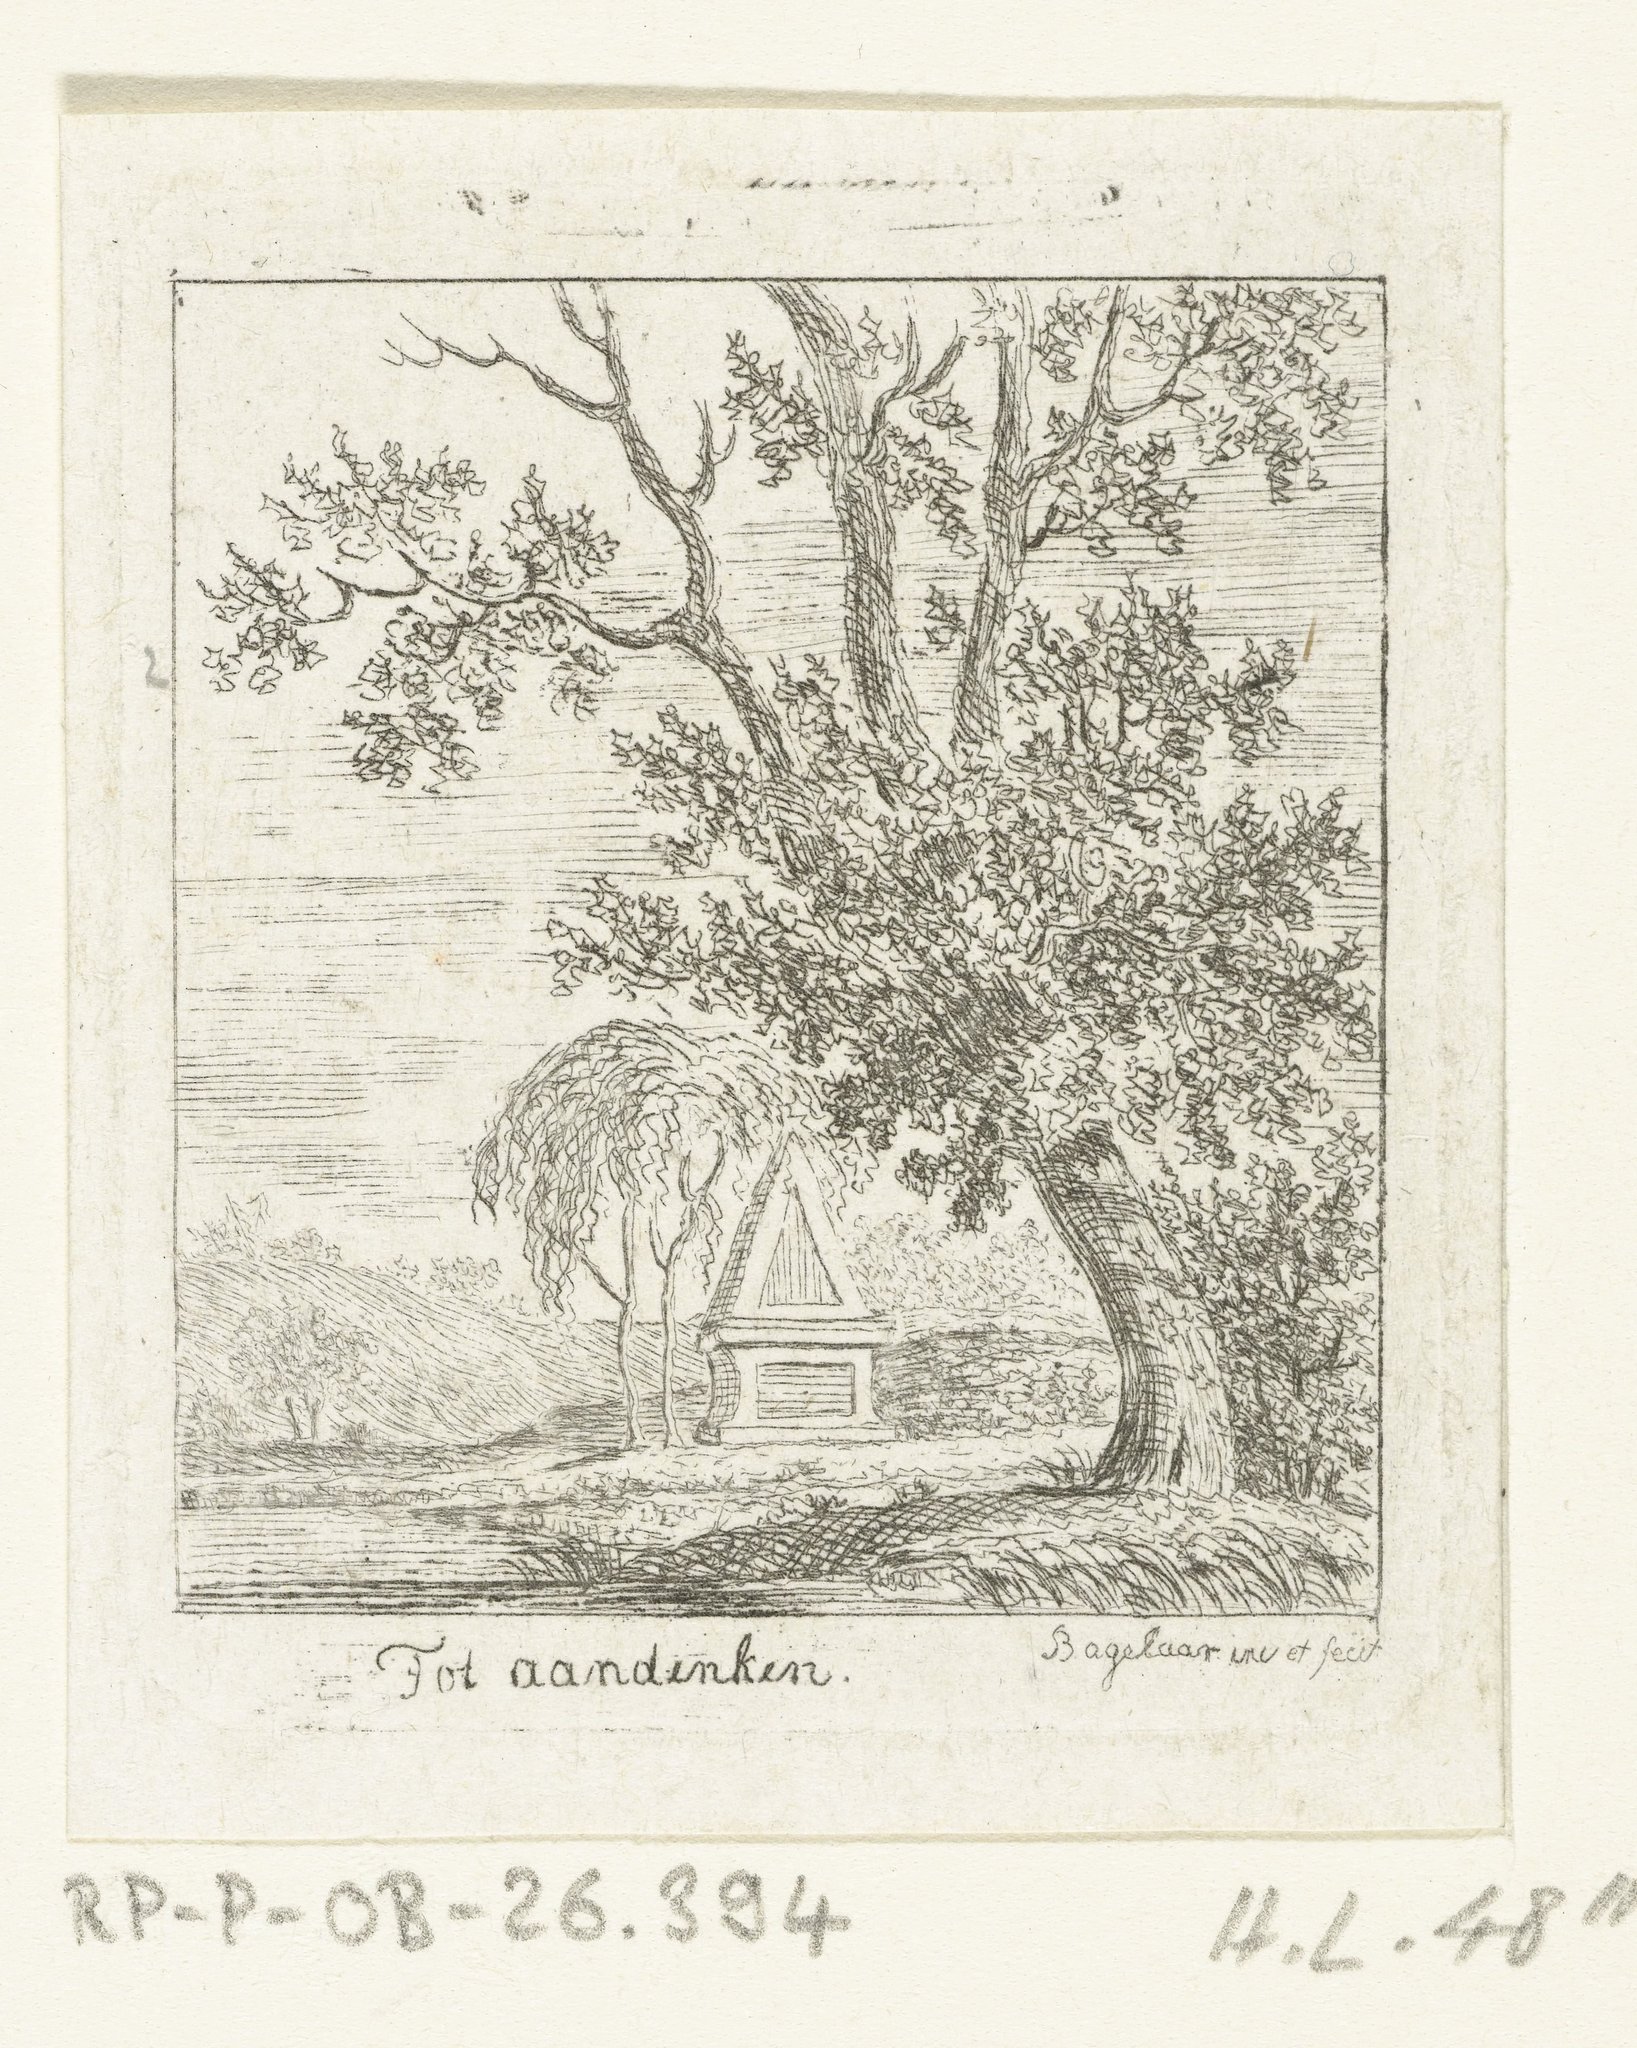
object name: print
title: Landschap met grafmonument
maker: ernst willem jan bagelaar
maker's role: draughtsman, print maker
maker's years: 1775-1837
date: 1798-1837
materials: paper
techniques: etching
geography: netherlands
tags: grave-building, monumental tomb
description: Landschap met grafmonument. In de ondermarge de tekst: Tot aandenken.